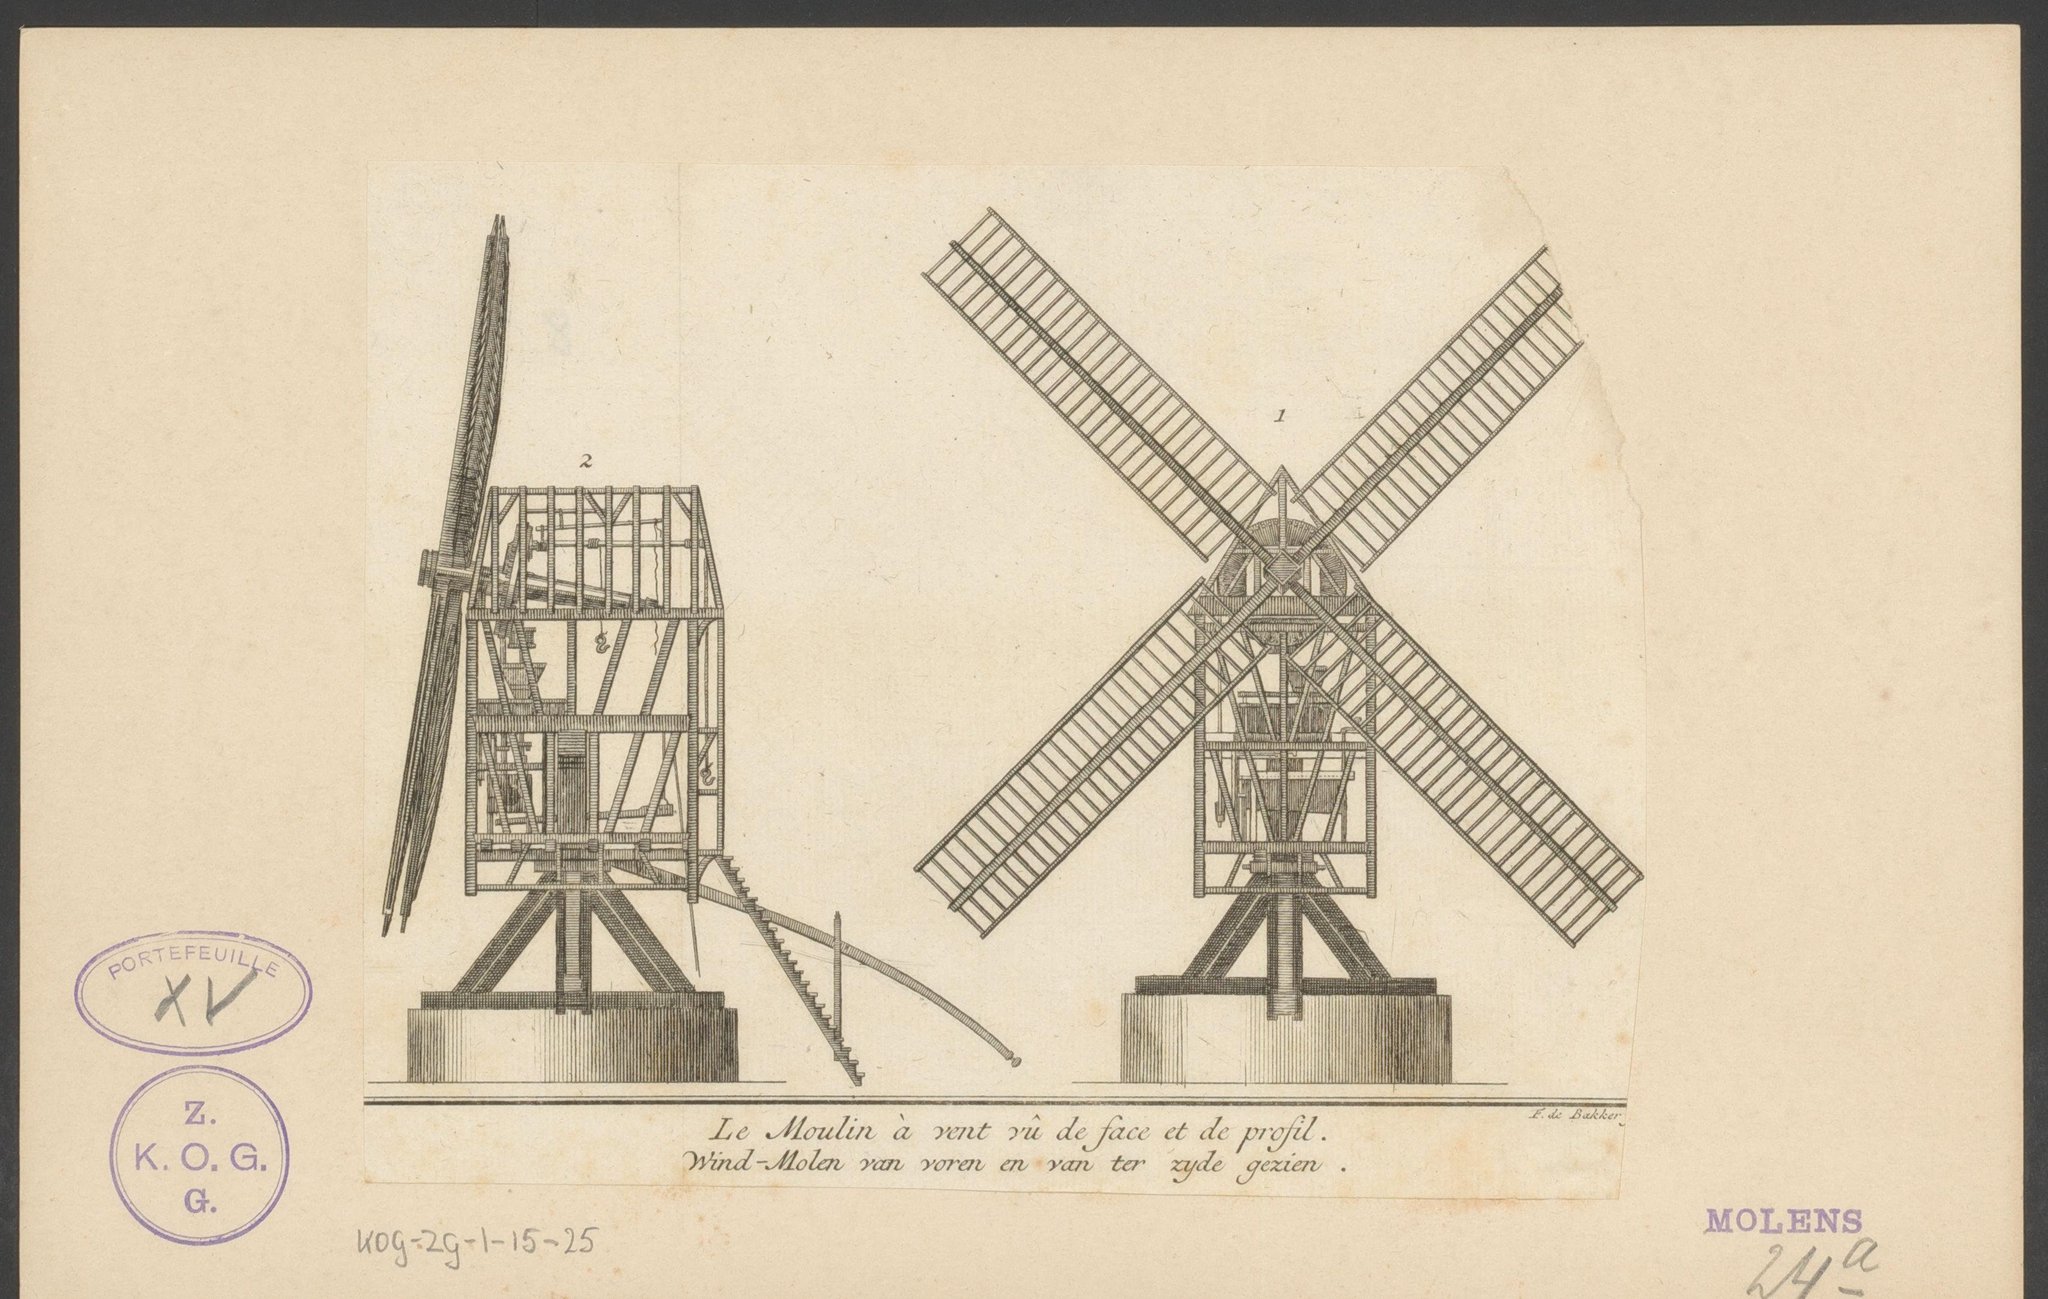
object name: print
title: Le Moulin à vent vû de face et de profil / Wind-molen van voren en van ter zijde gezien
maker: frans de bakker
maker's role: print maker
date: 1748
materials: paper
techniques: engraving, etching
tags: tapestry weaver, gobelin maker, textile industry and clothing industry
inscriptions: collector's mark: Lugt 1641, stamp, stamp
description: Prent mogelijk uit: Noël-Antoine Pluche. Schouwtoneel der natuur, of Samenspraaken over de Bysonderheden der natuurlyke histori (...). [Vertaald uit het Frans door] Pieter le Clercq. 14 dln. Amsterdam: Salomon Schouten, 1737-1749, dl. 10, na p. 192.